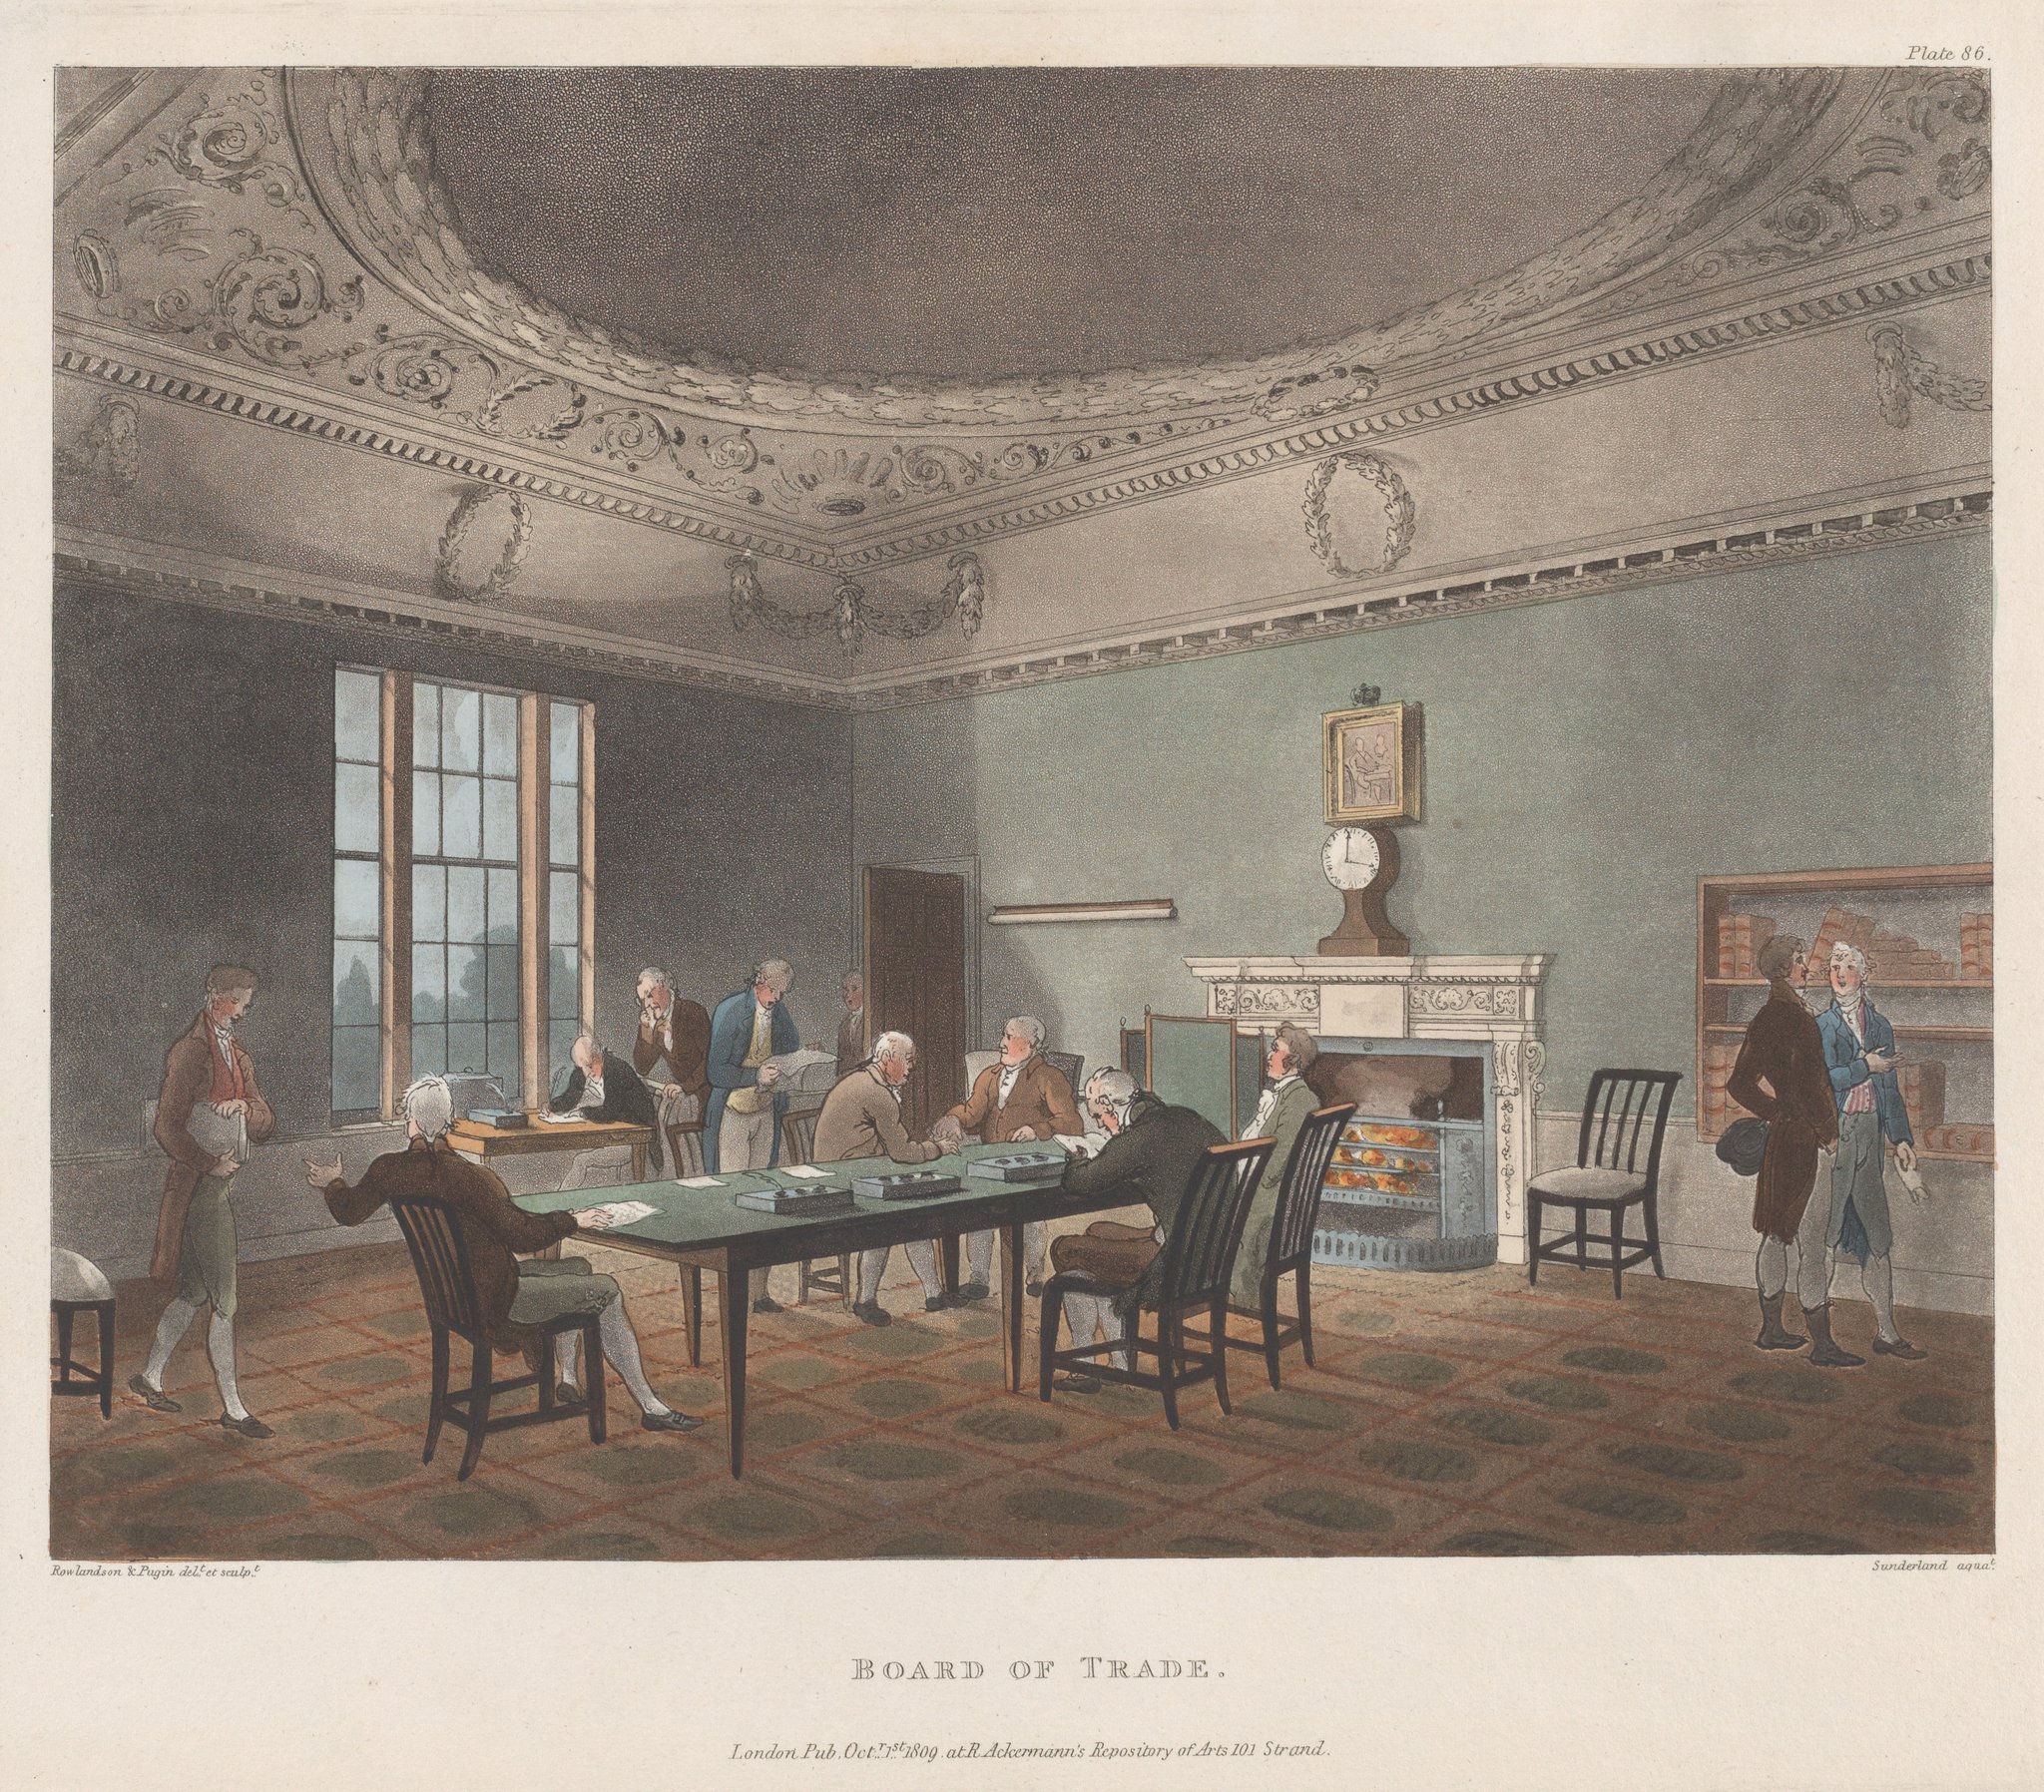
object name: print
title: Board of Trade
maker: thomas rowlandson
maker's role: artist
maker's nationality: british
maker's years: 1757-1827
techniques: aquatint, etching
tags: government,interiors,men